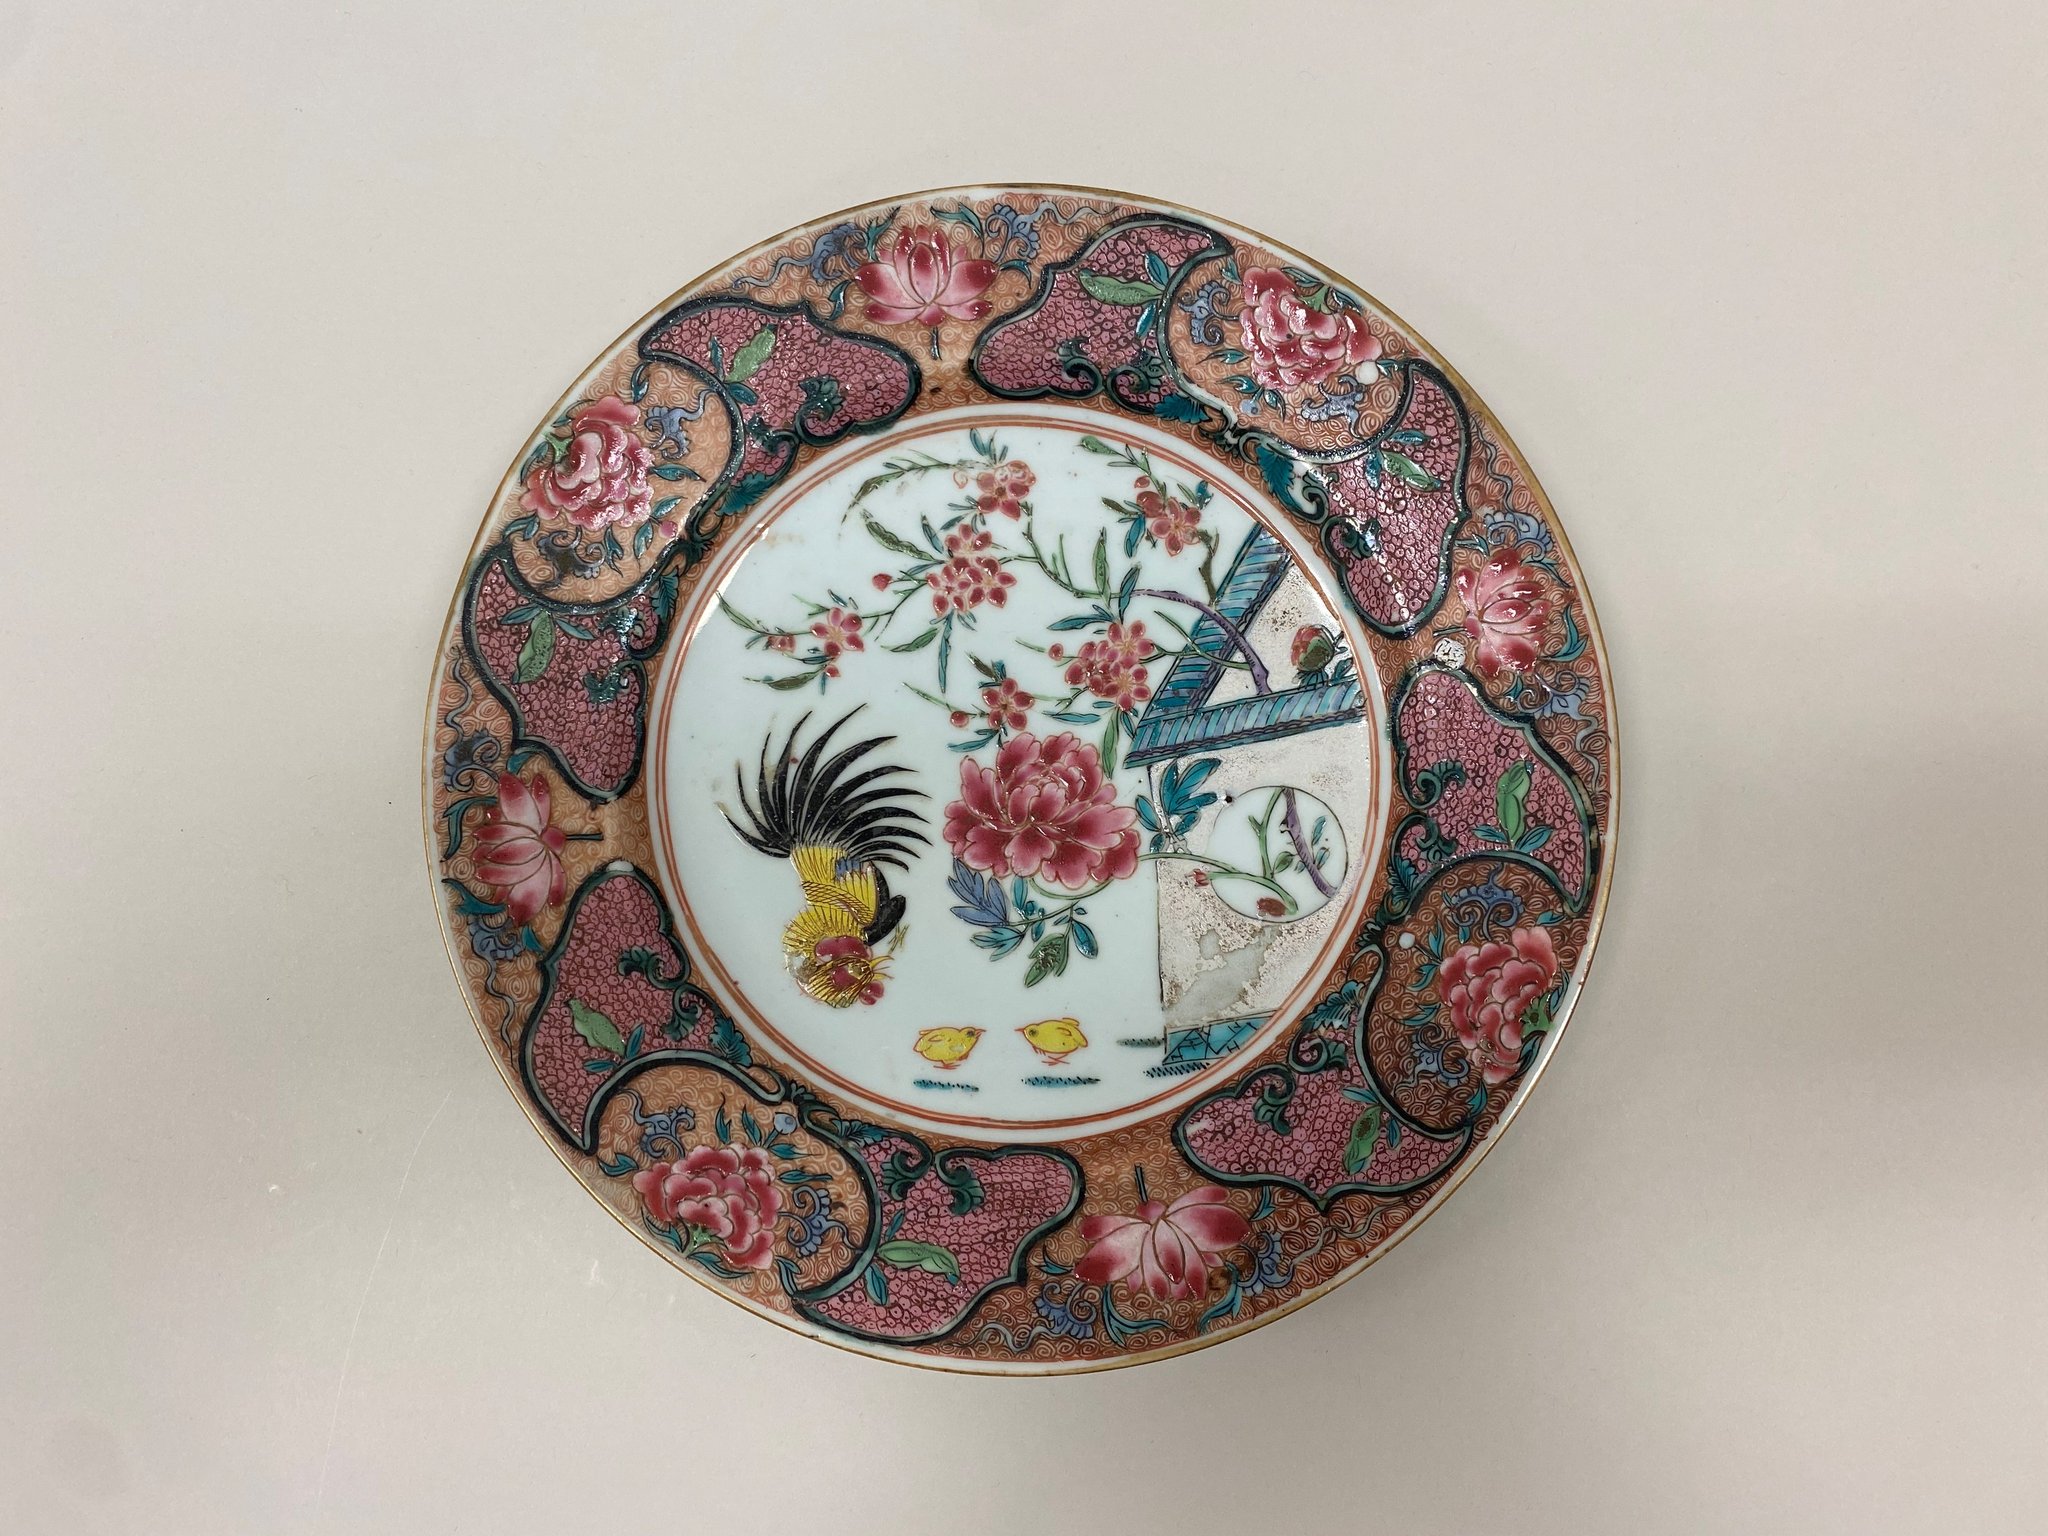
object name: plate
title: Plate with flowers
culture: chinese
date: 1767-1800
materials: enamel, porcelain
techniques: overglaze, painting, polychrome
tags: roosters,flowers